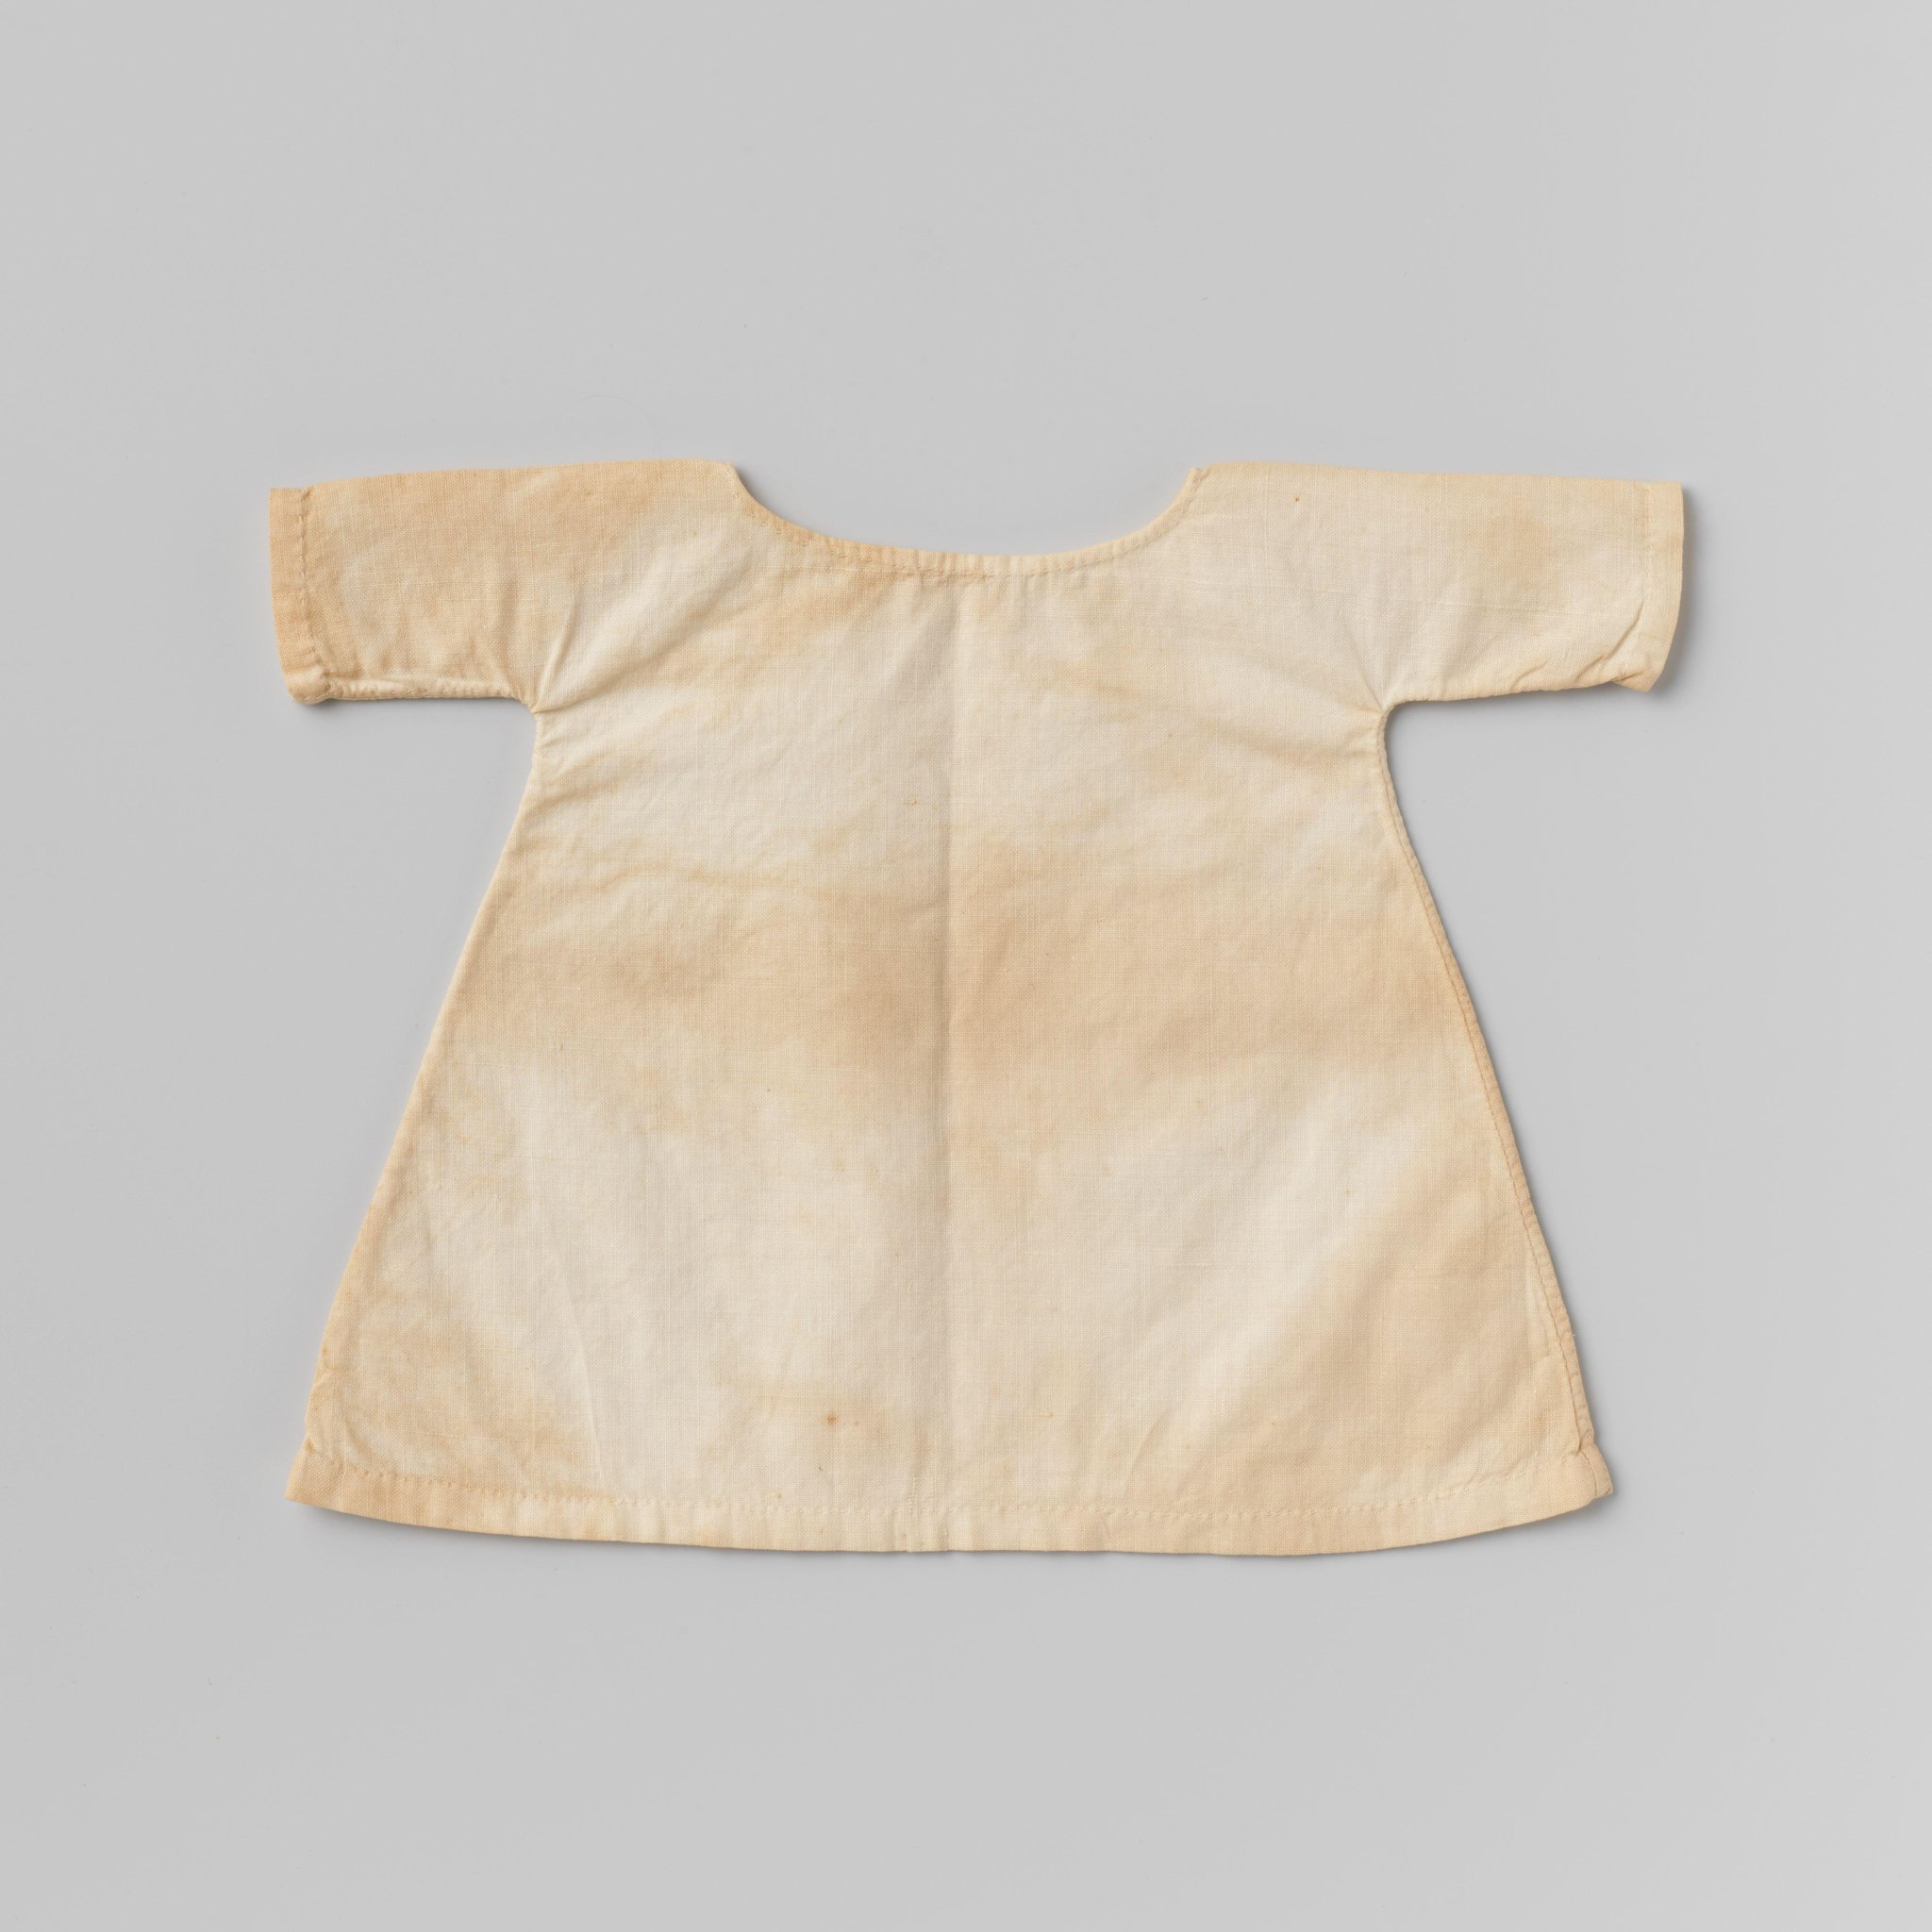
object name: miniature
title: Hemd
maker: Anonymous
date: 1750-1800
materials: cotton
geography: netherlands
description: Een lange hemd (voor man, vrouw, kind?) van fijn katoen een zeer netjes afgewerkt met smalle Engelse naden.